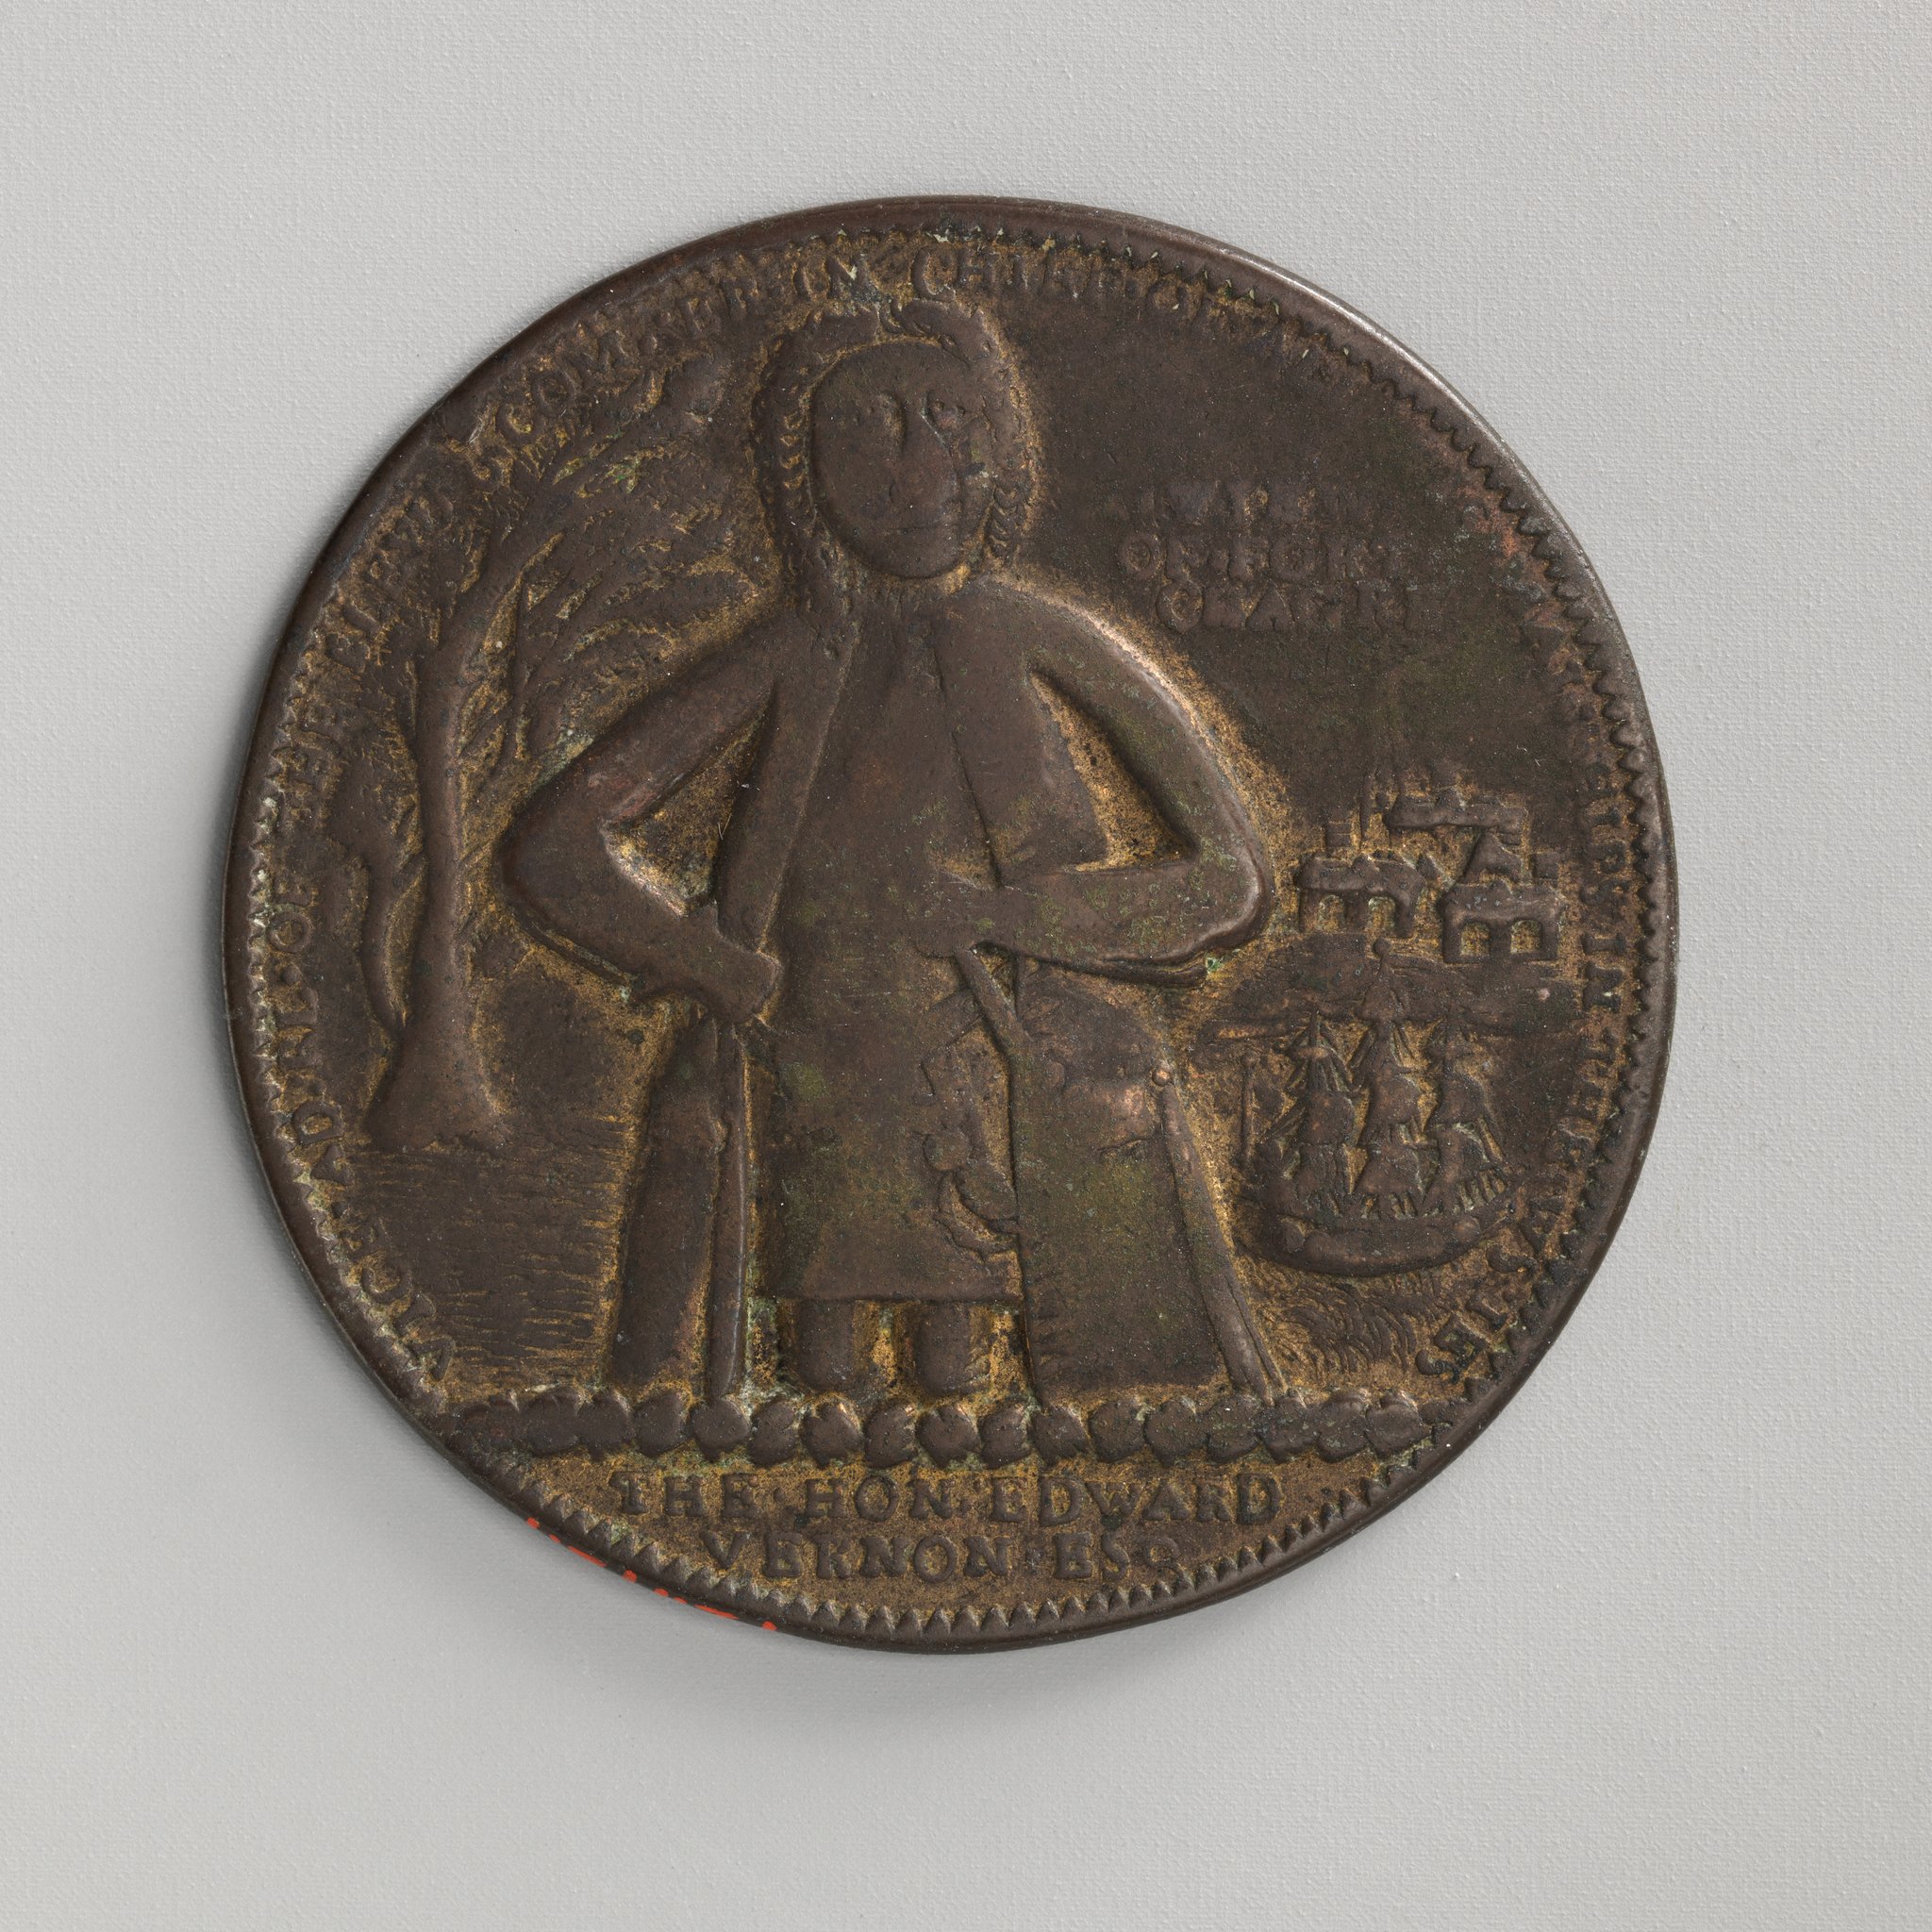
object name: medal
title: Admiral Vernon's taking of Porto Bello, 1739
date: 1701-1800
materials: brass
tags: men,trees,admirals